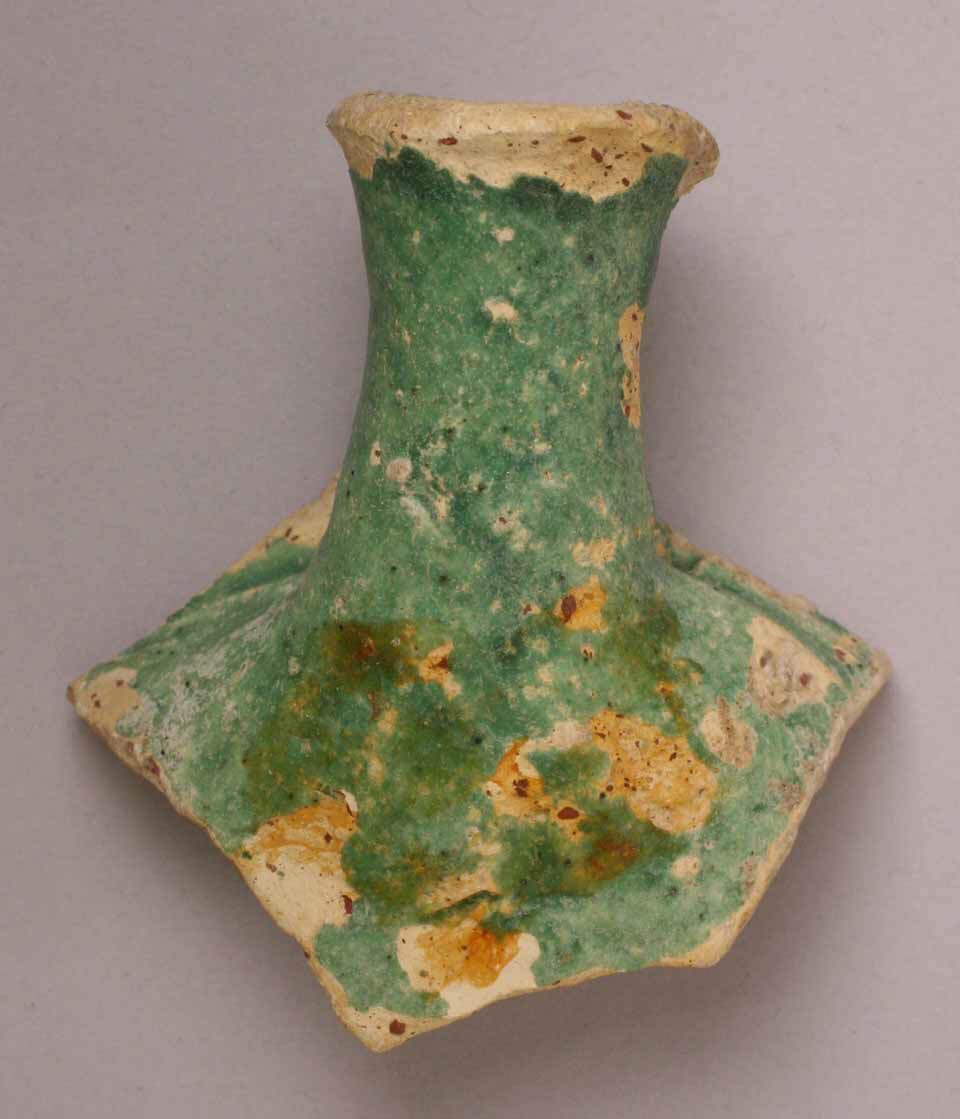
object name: fragment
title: Ceramic Fragment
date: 801-1000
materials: earthenware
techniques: glazing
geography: saudi arabia